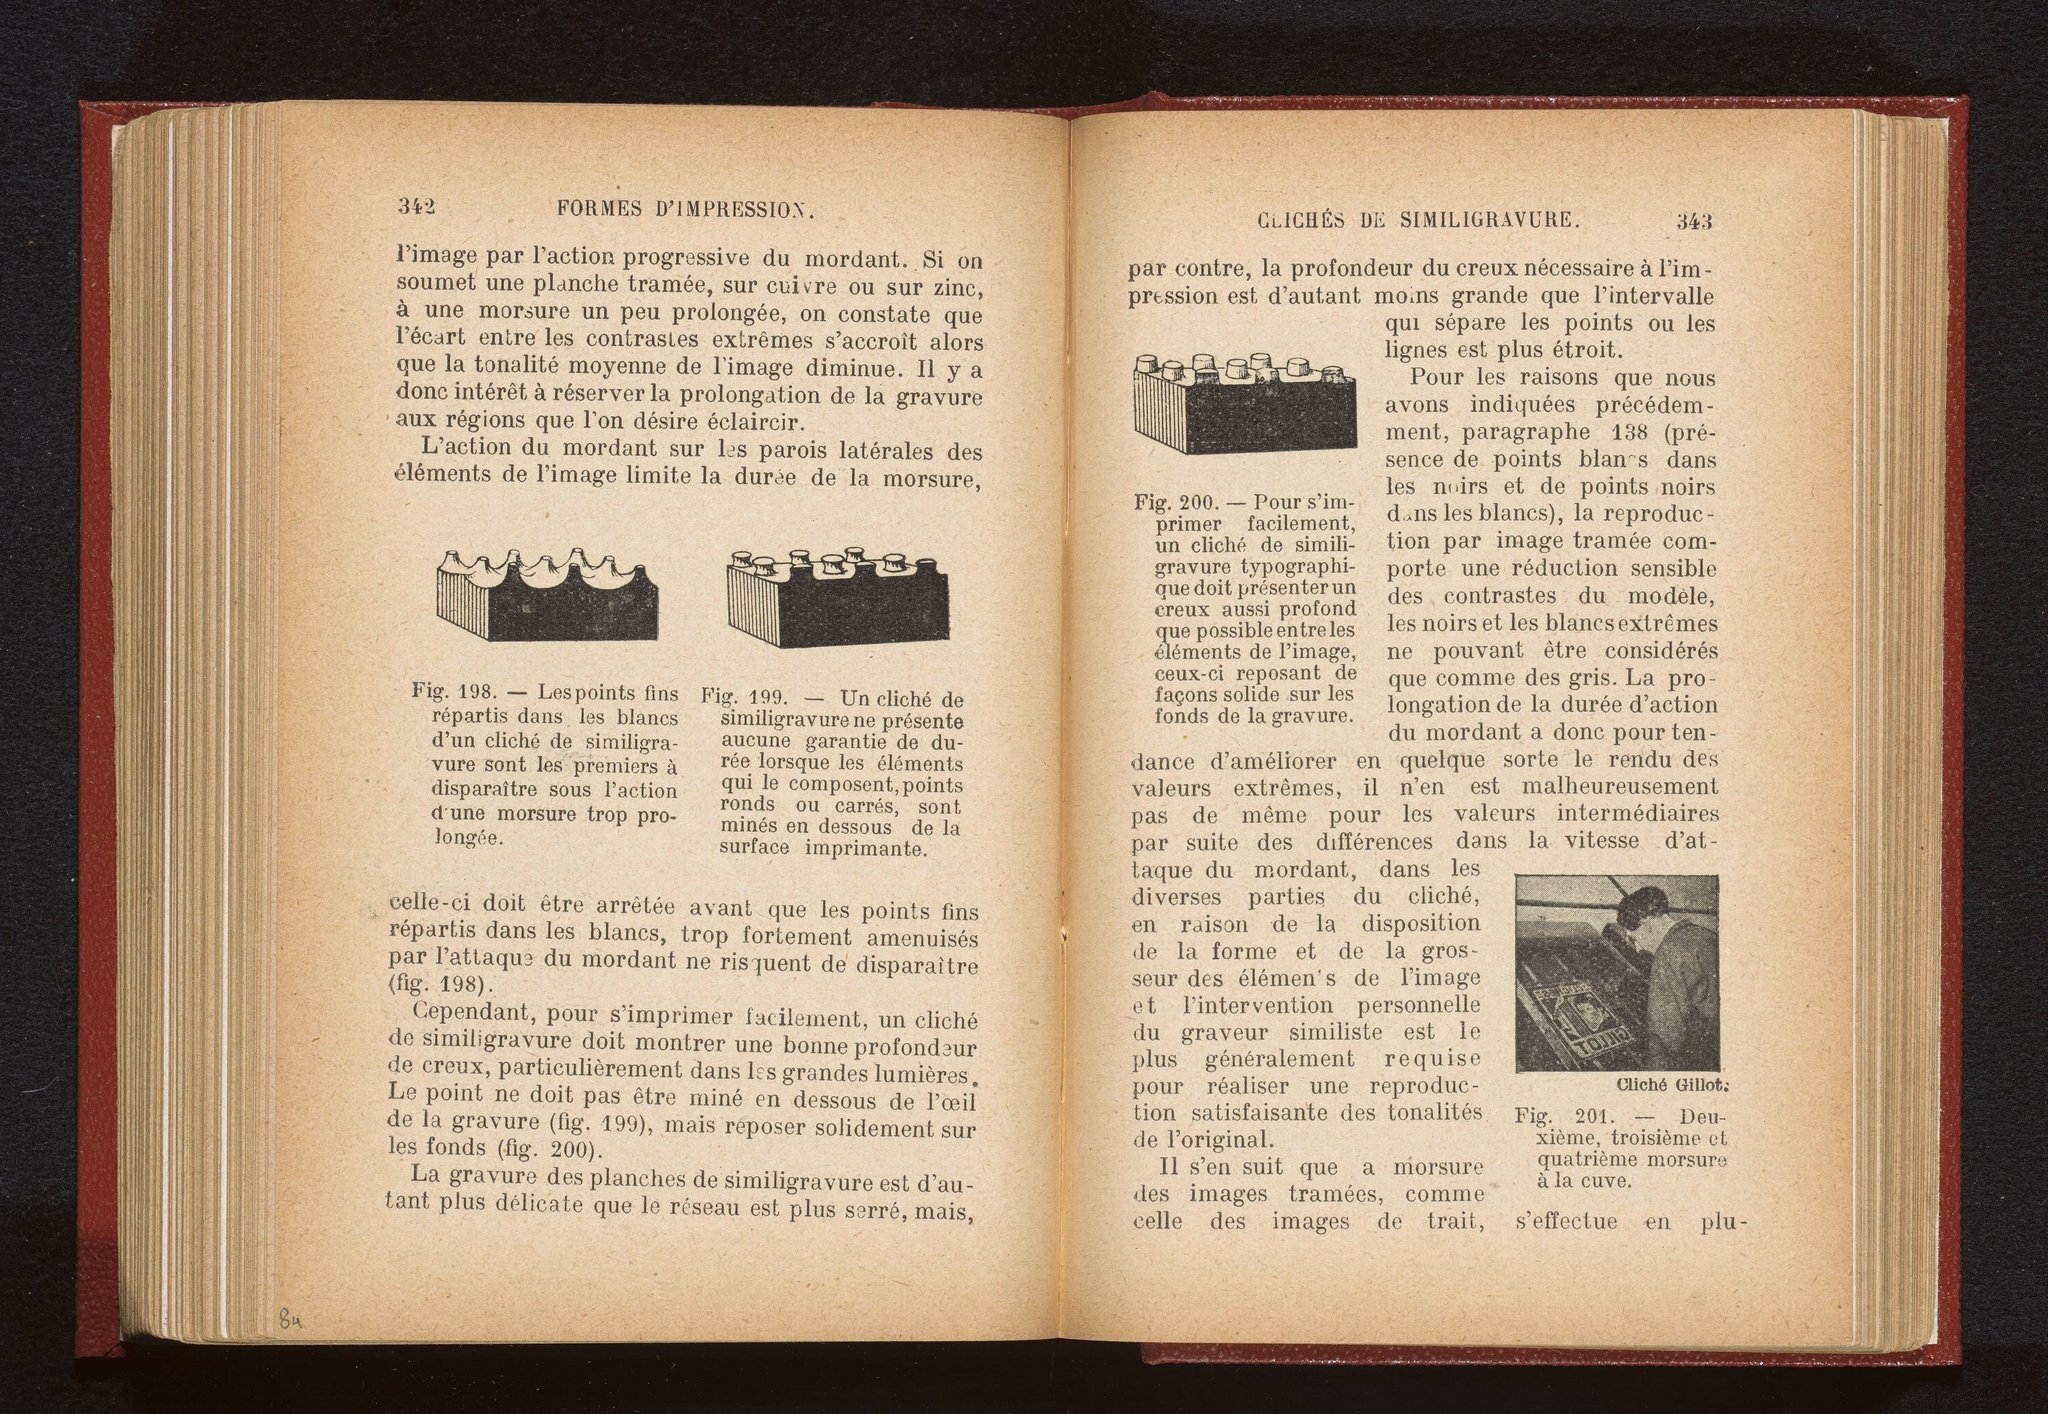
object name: photomechanical print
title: Man die een plaat voor een fotomechanische afdruk bekijkt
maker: Anonymous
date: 1922-1932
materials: paper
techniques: autotype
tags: print, e.g.: engraving, etching, lithograph, photographic apparatus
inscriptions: number: ‘Fig. 201.’